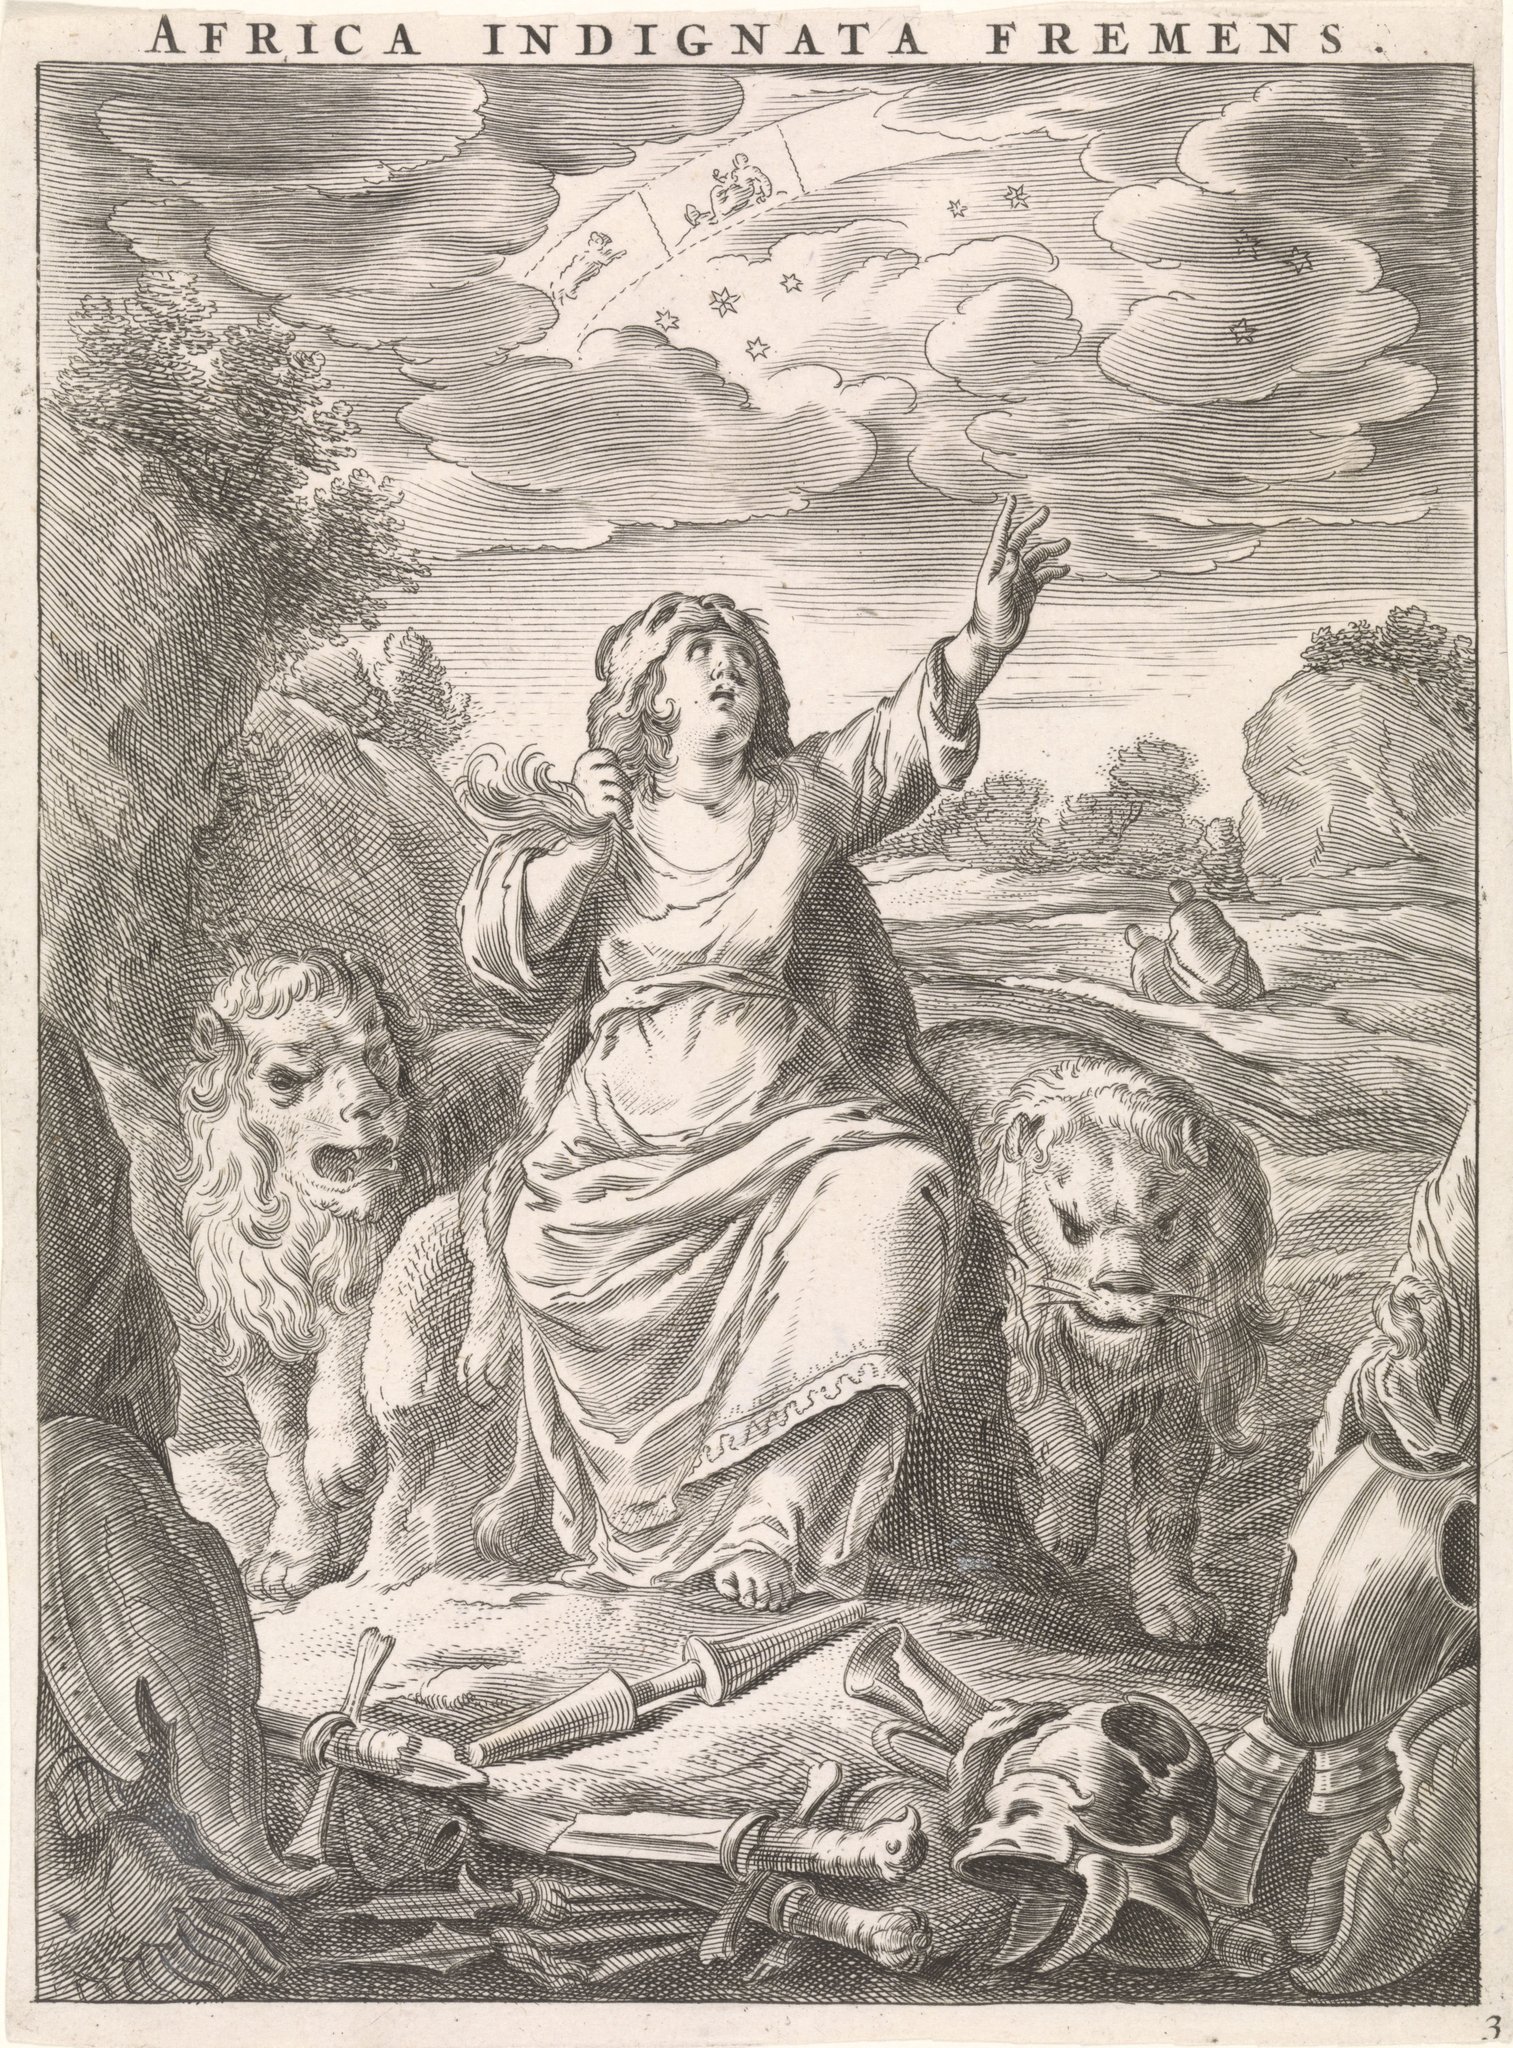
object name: print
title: Vrouwelijke personificatie van werelddeel Afrika als vrouw met leeuwenvel zittend tussen leeuwen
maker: cornelis van dalen (ii)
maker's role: draughtsman, print maker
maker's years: 1638-1664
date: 1648-1664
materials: paper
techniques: engraving, etching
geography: amsterdam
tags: africa represented allegorically; 'africa' (ripa), beasts of prey, predatory animals: lion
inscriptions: collector's mark: Lugt 2228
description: Personificatie van werelddeel Afrika als vrouw met leeuwenvel zittend tussen leeuwen. Zij gebaart naar de hemel waar tekens van de dierenriem zichtbaar zijn. Volgens de titel om haar verontwaardiging te uiten. Op de voorgrond ligt een wapenrusting.